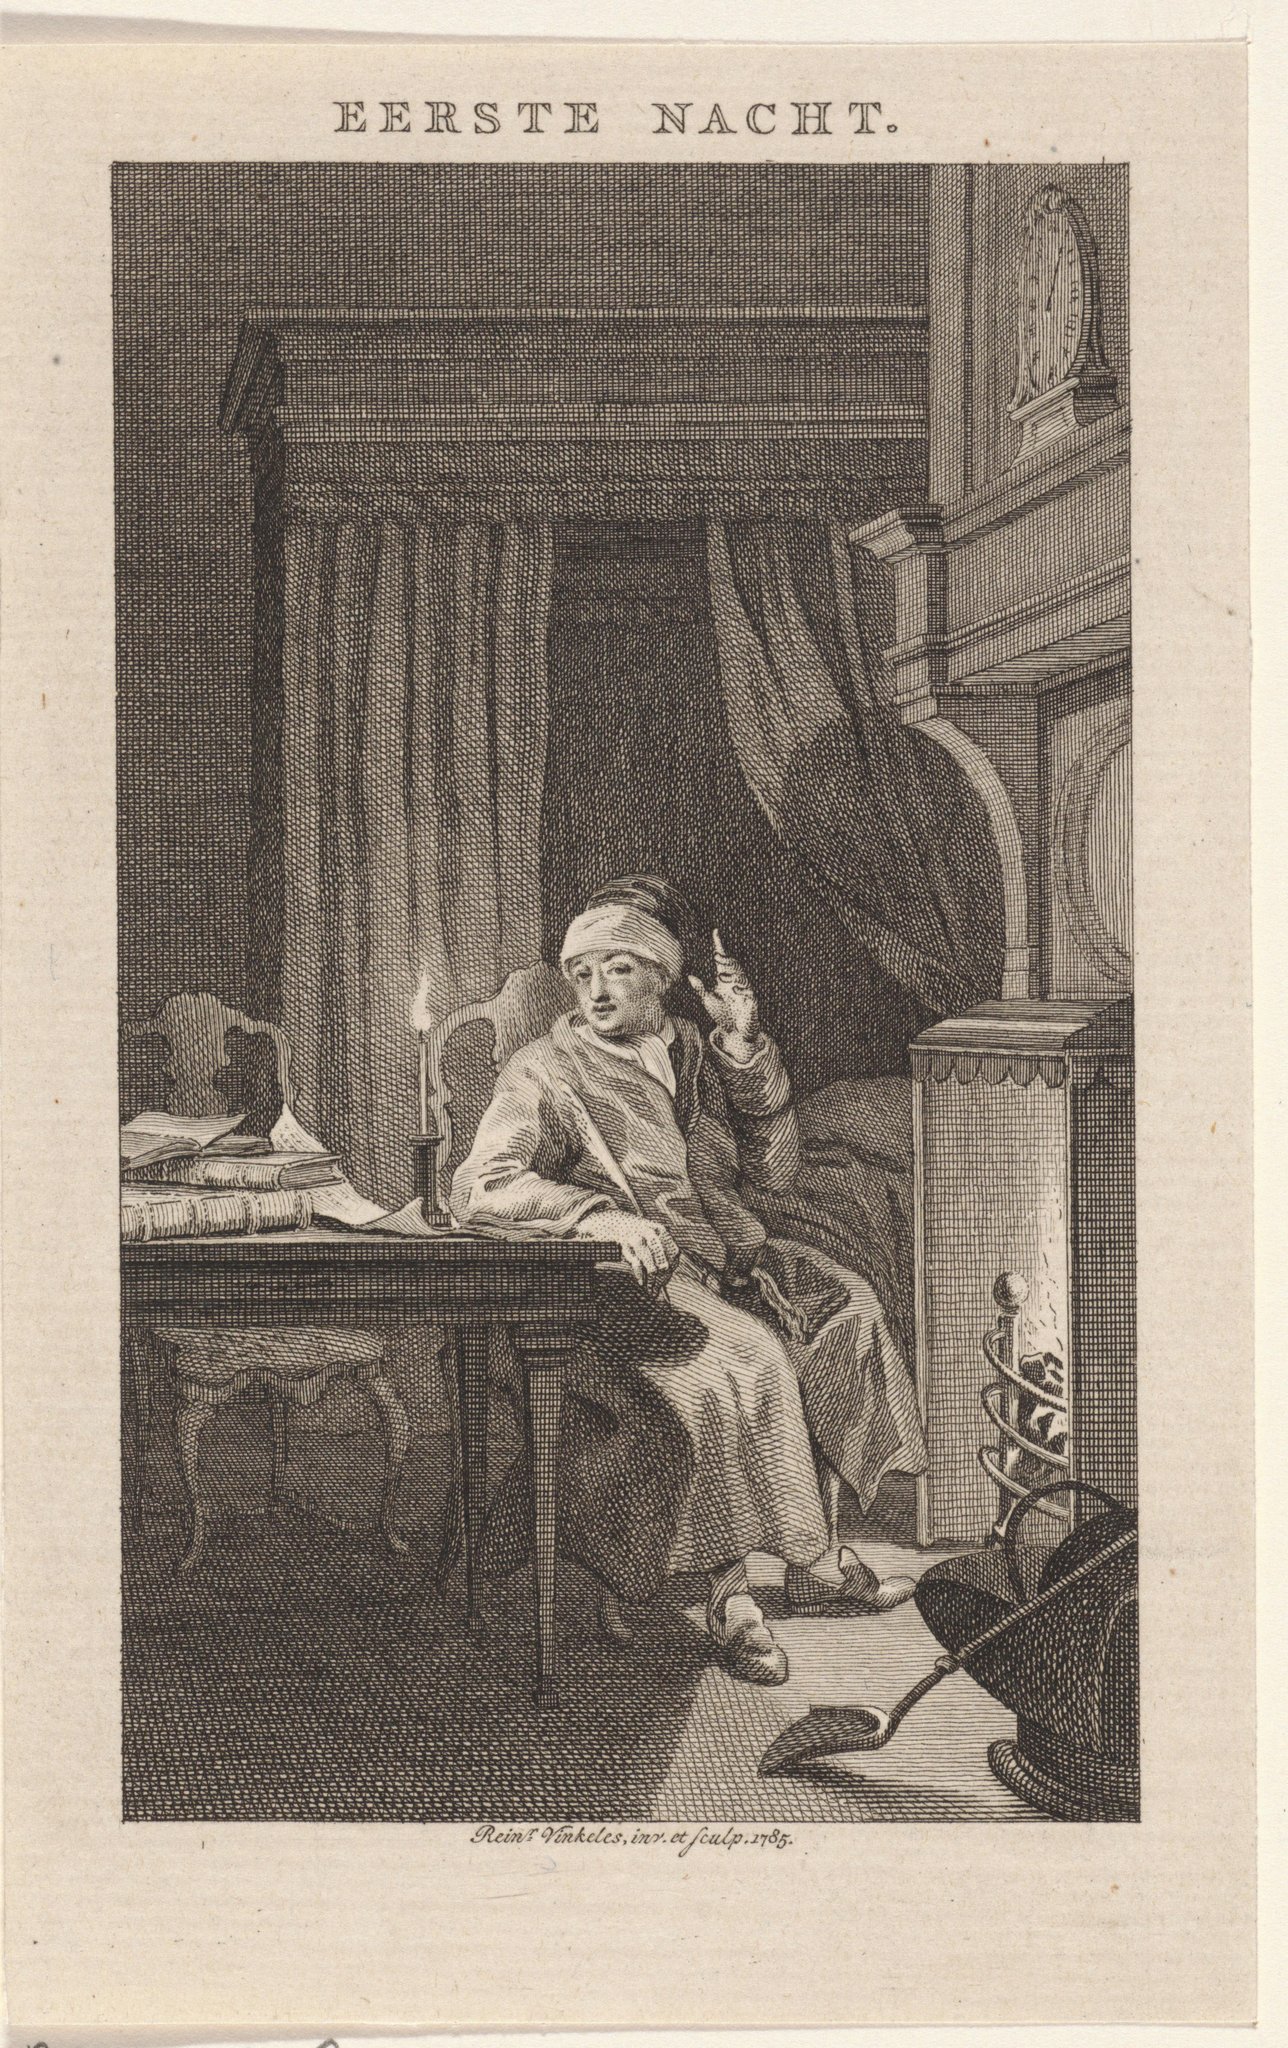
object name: print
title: Man met een slaapmuts zit naast zijn bed bij de haard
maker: reinier vinkeles (i)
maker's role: draughtsman, print maker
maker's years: 1741-1816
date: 1785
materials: paper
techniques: engraving, etching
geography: amsterdam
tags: nightwear: night-cap, open hearth, fire-place, night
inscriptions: collector's mark: Lugt 2228